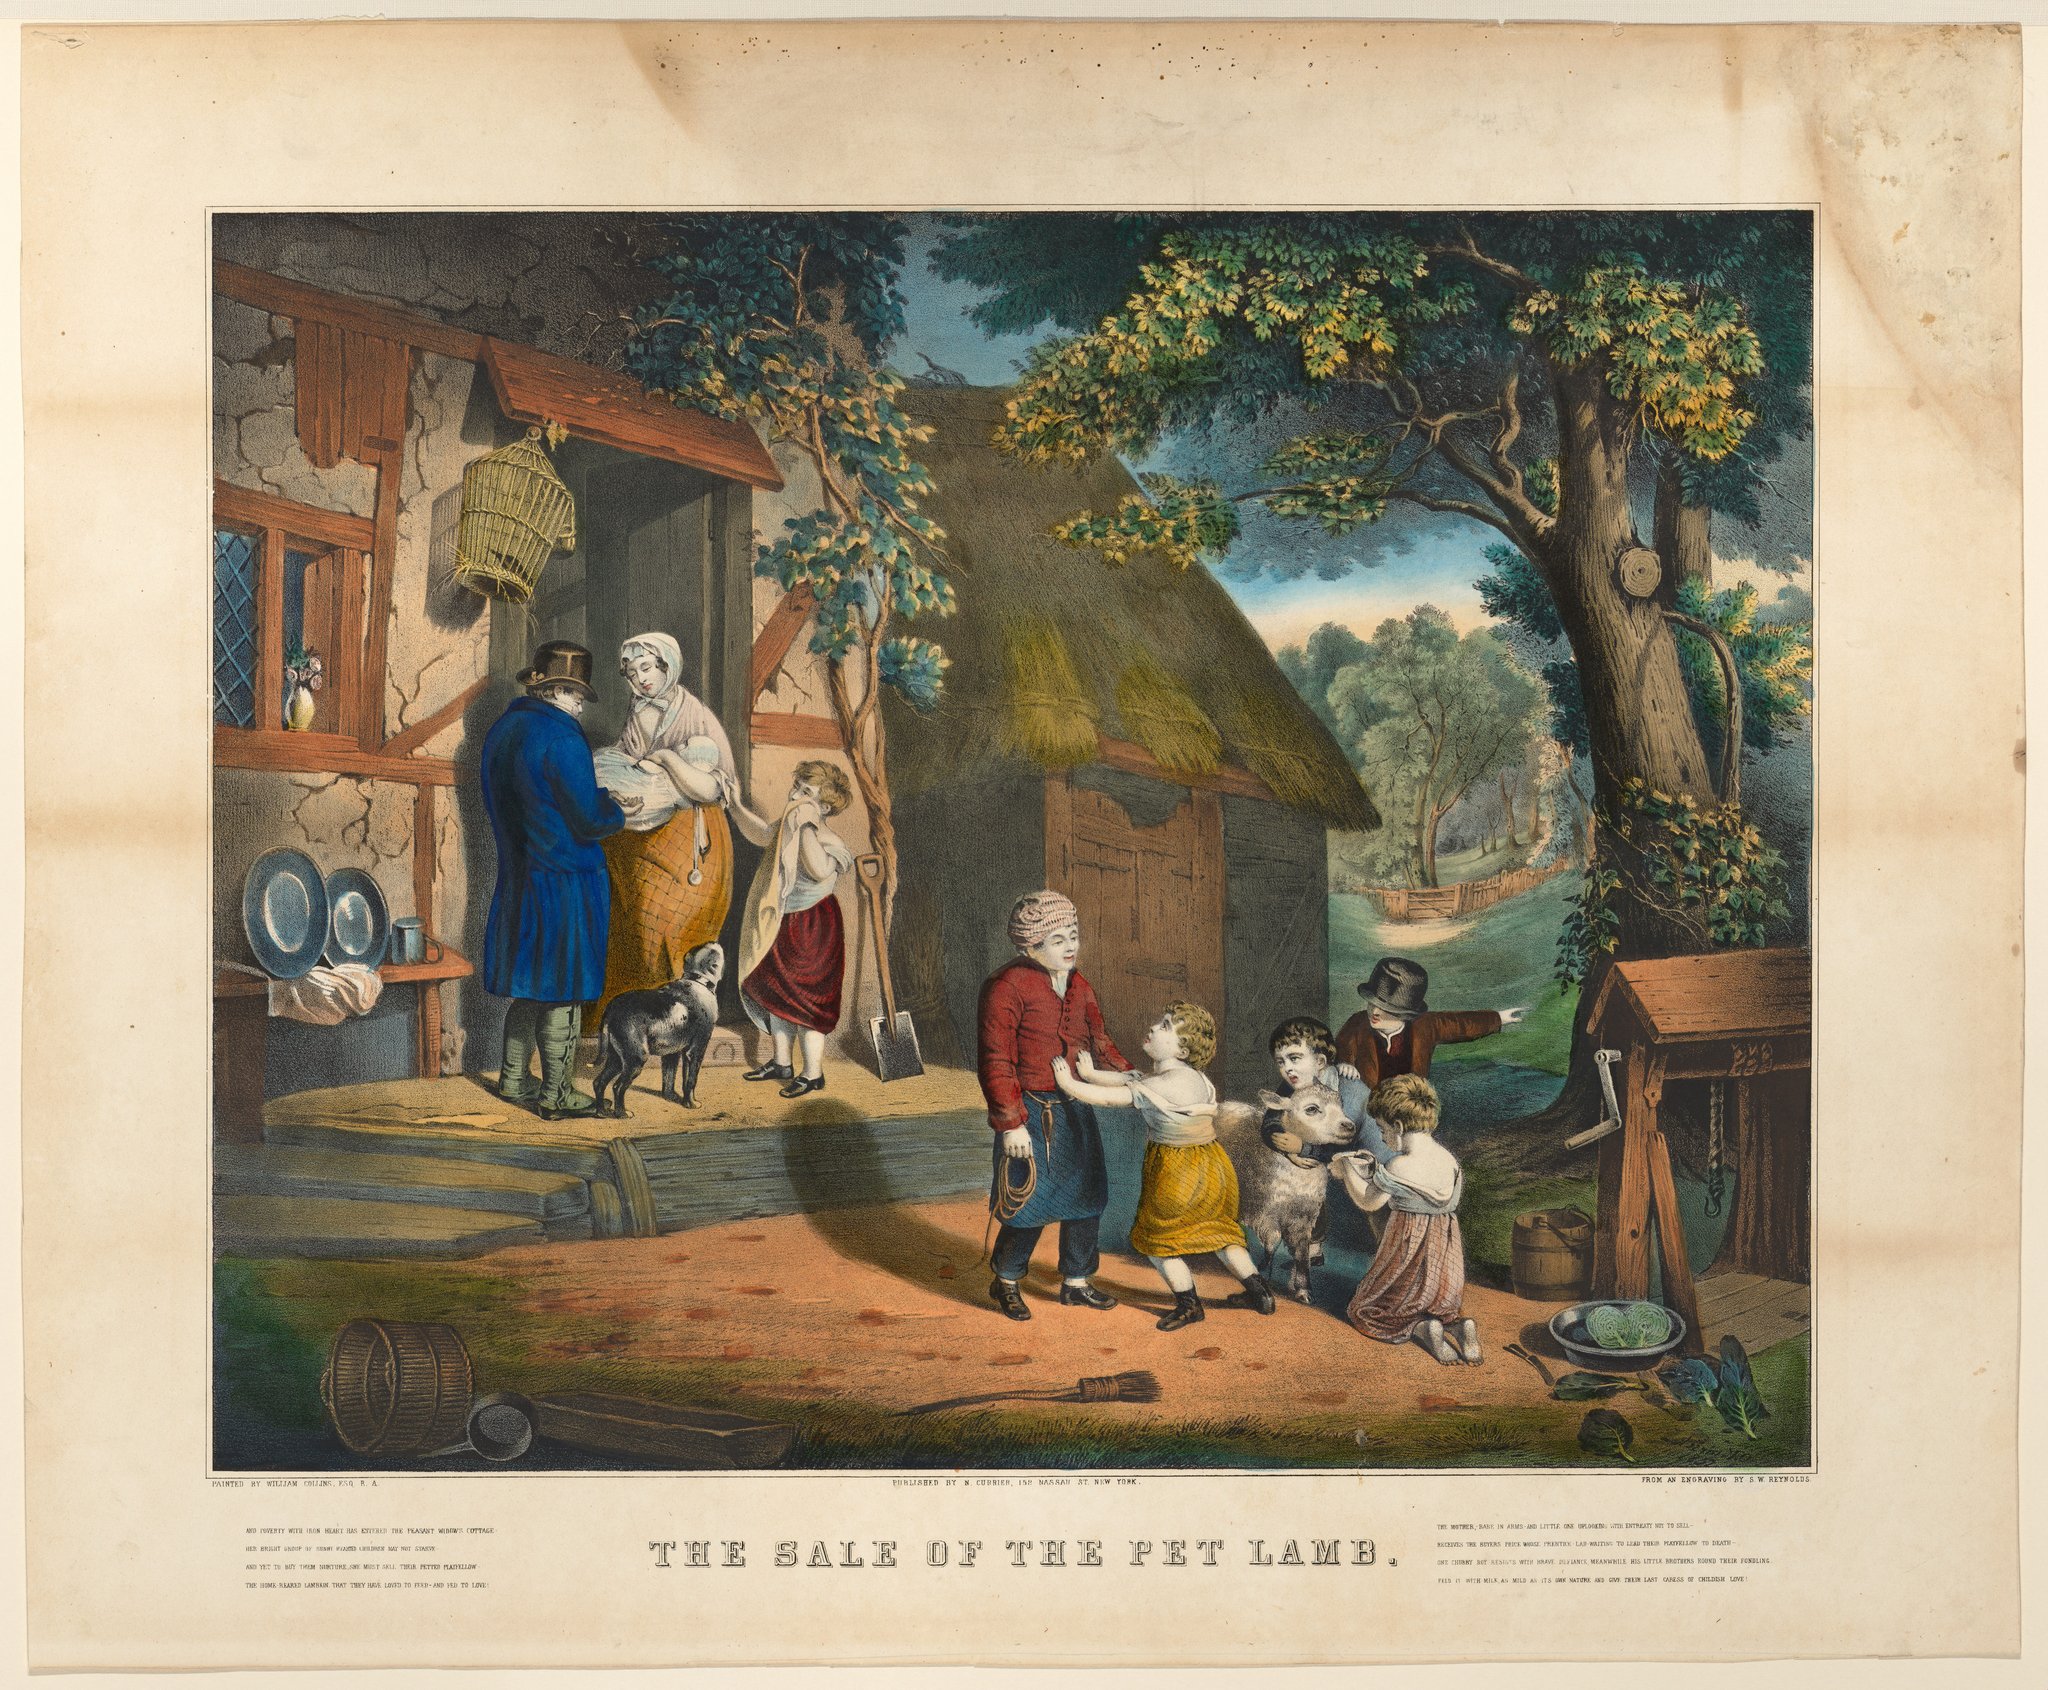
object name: print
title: The Sale of the Pet Lamb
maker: otto knirsch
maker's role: artist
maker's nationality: american, born germany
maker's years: 1853-1867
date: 1857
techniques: hand coloring, lithograph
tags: children,dogs,lambs